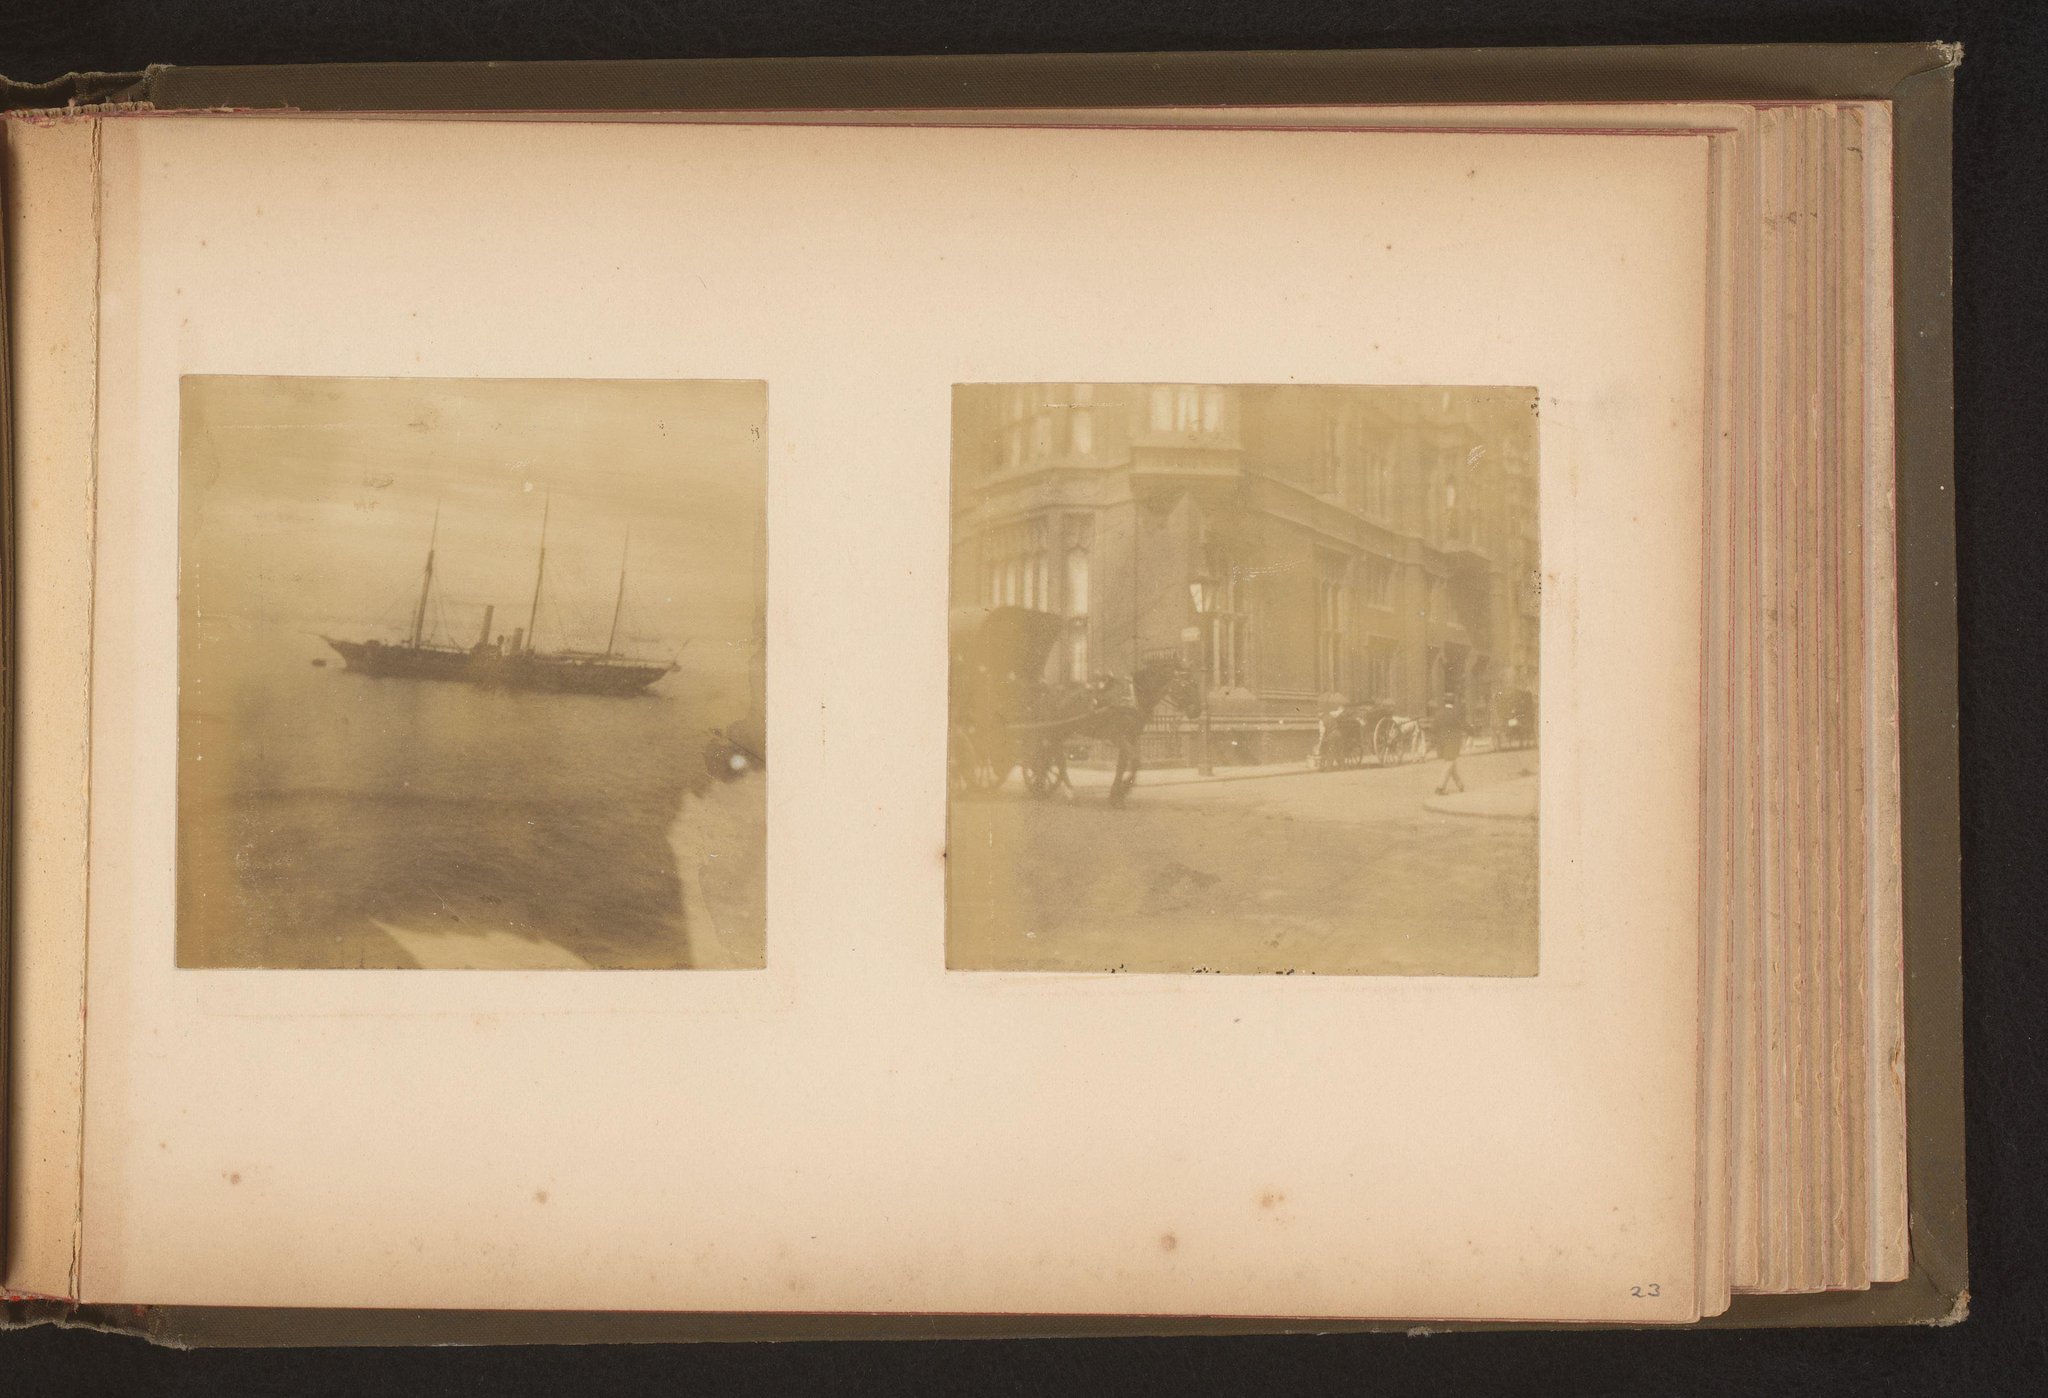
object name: photograph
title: Twee foto's van een stoomschip en een straathoek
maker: Anonymous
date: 1895-1910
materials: paper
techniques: albumen print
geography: great britain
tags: street, steamship, motorship, great britain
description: Deze foto's maken deel uit van een album.